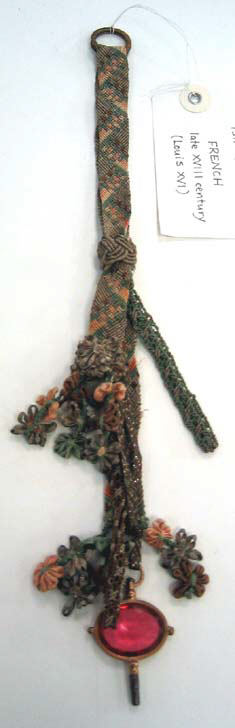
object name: fob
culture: french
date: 1767-1800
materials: glass, metal thread, silk